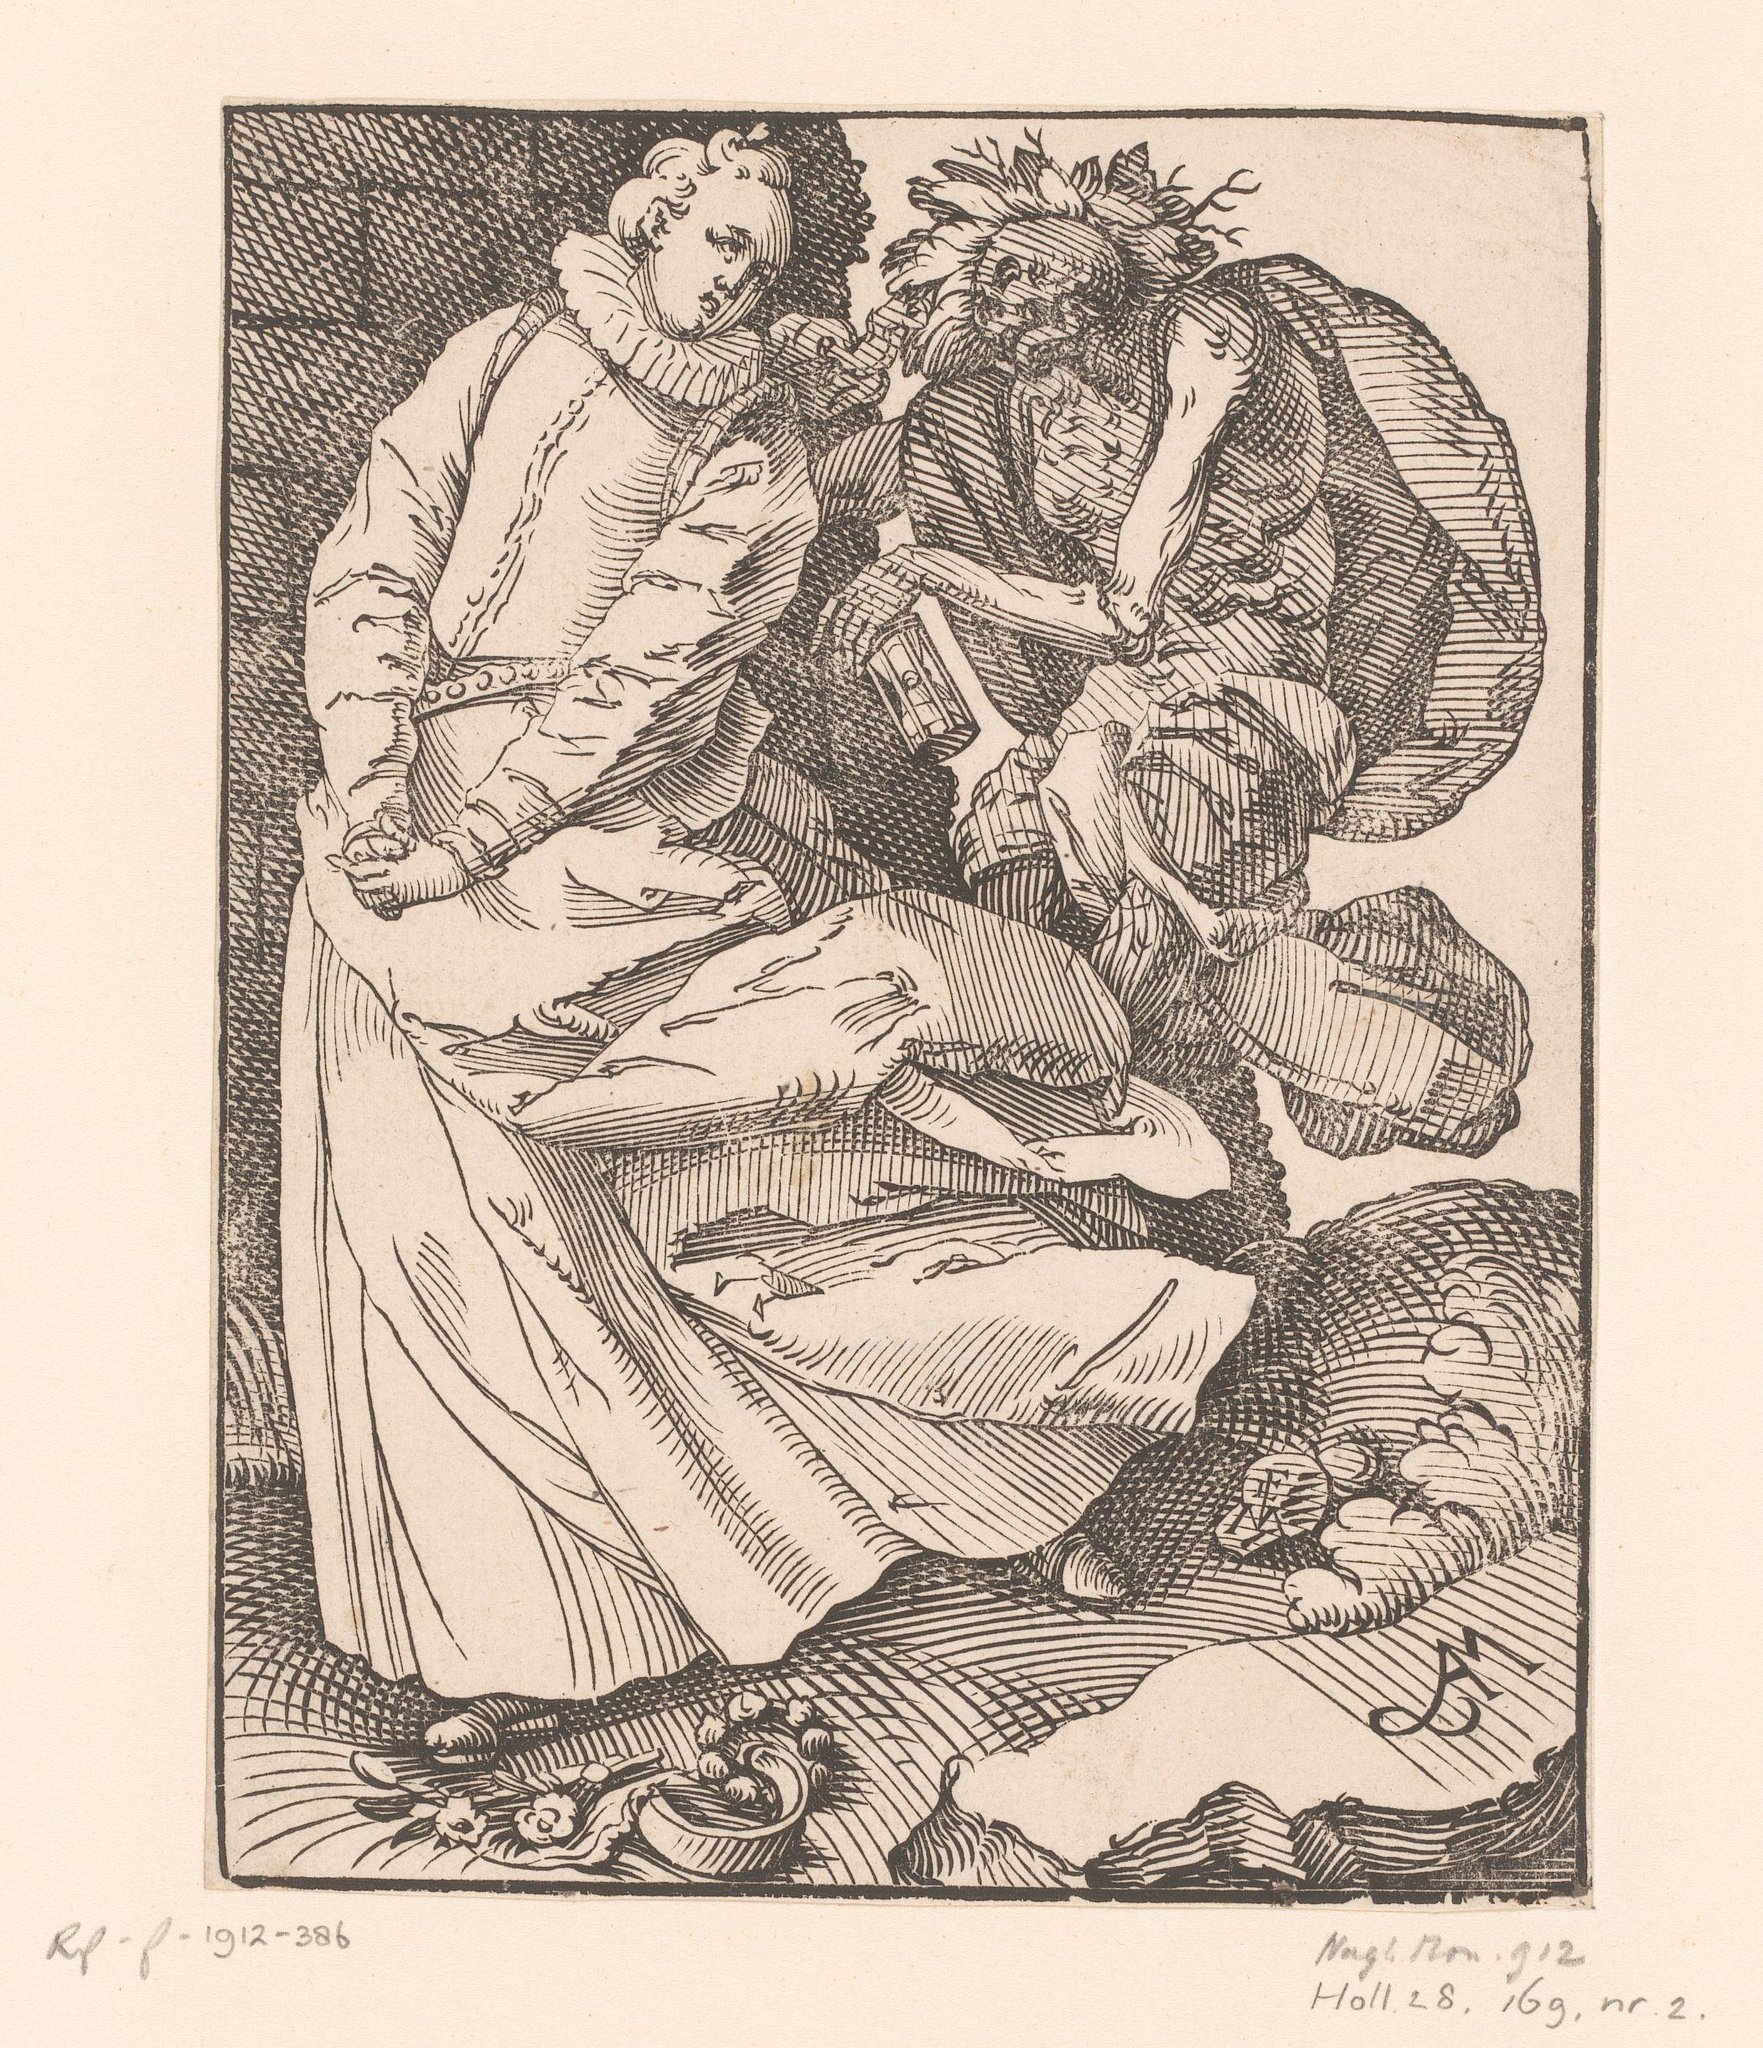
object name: print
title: Jonge vrouw gegrepen door de Dood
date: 1573-1611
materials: paper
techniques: woodcut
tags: adolescent, young woman, maiden, death as skeleton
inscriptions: collector's mark: Lugt 1185, collector's mark: Lugt 2228